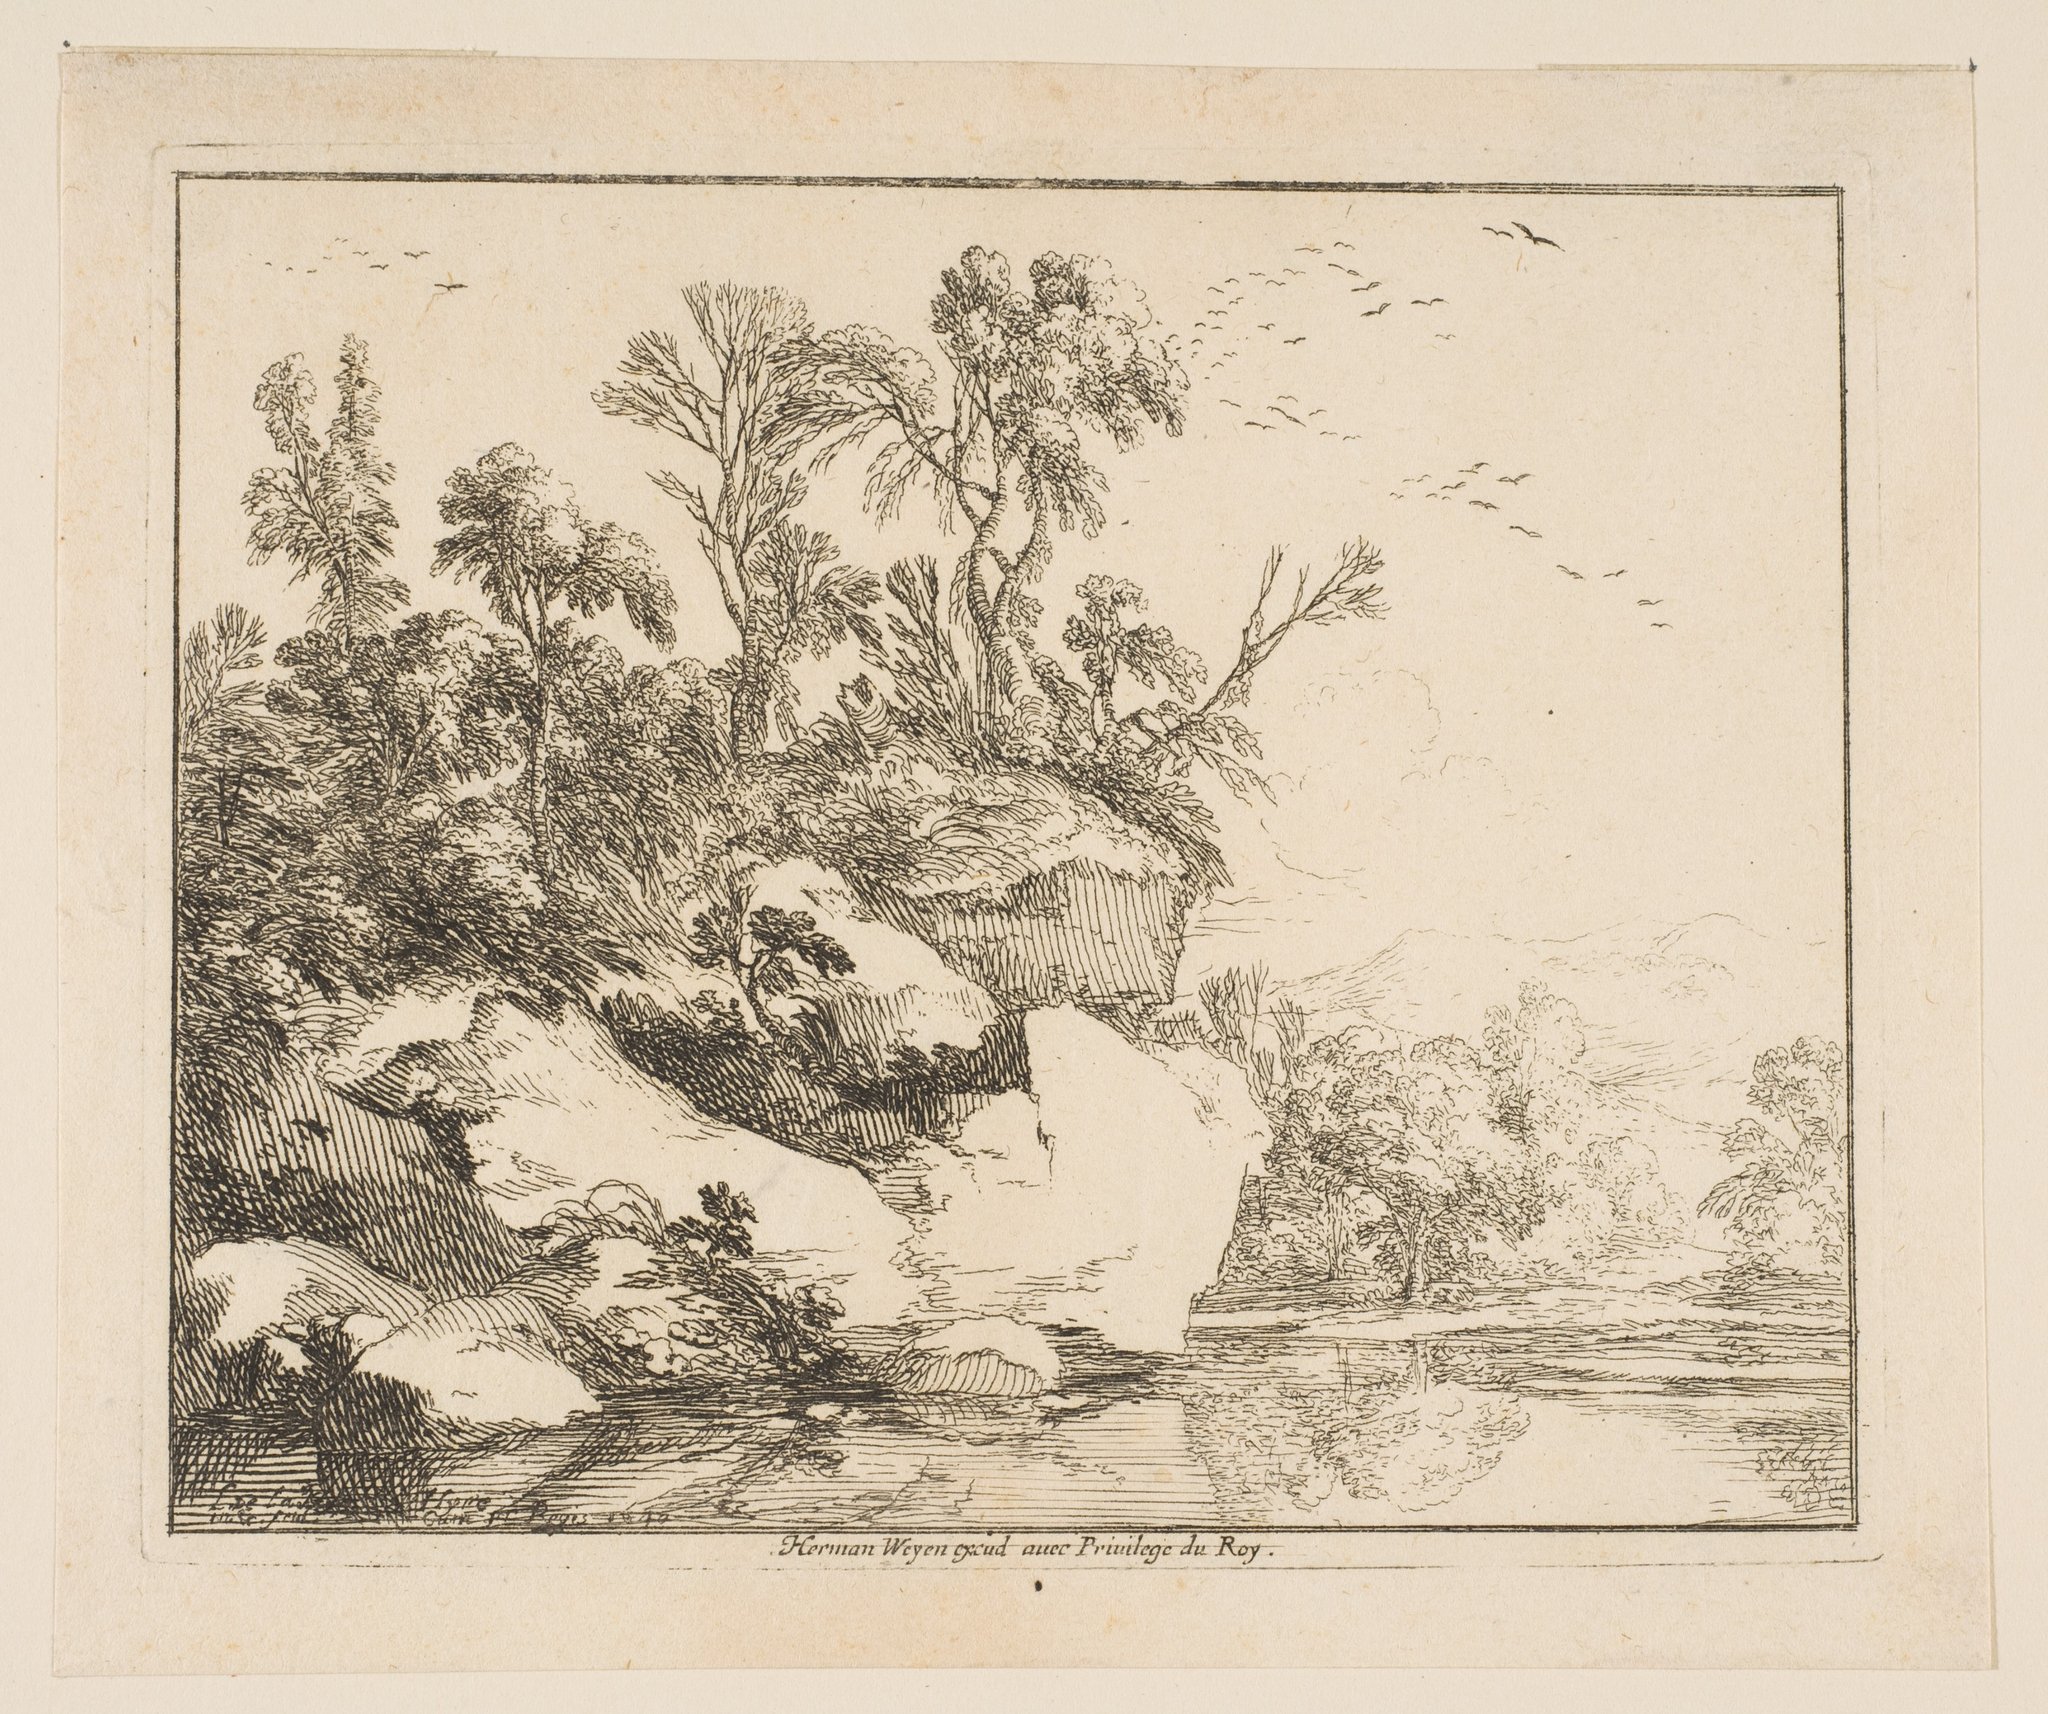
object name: print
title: The Covered Rocks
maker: laurent de la hyre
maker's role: artist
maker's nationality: french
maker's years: 1606-1656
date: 1640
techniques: etching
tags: landscapes